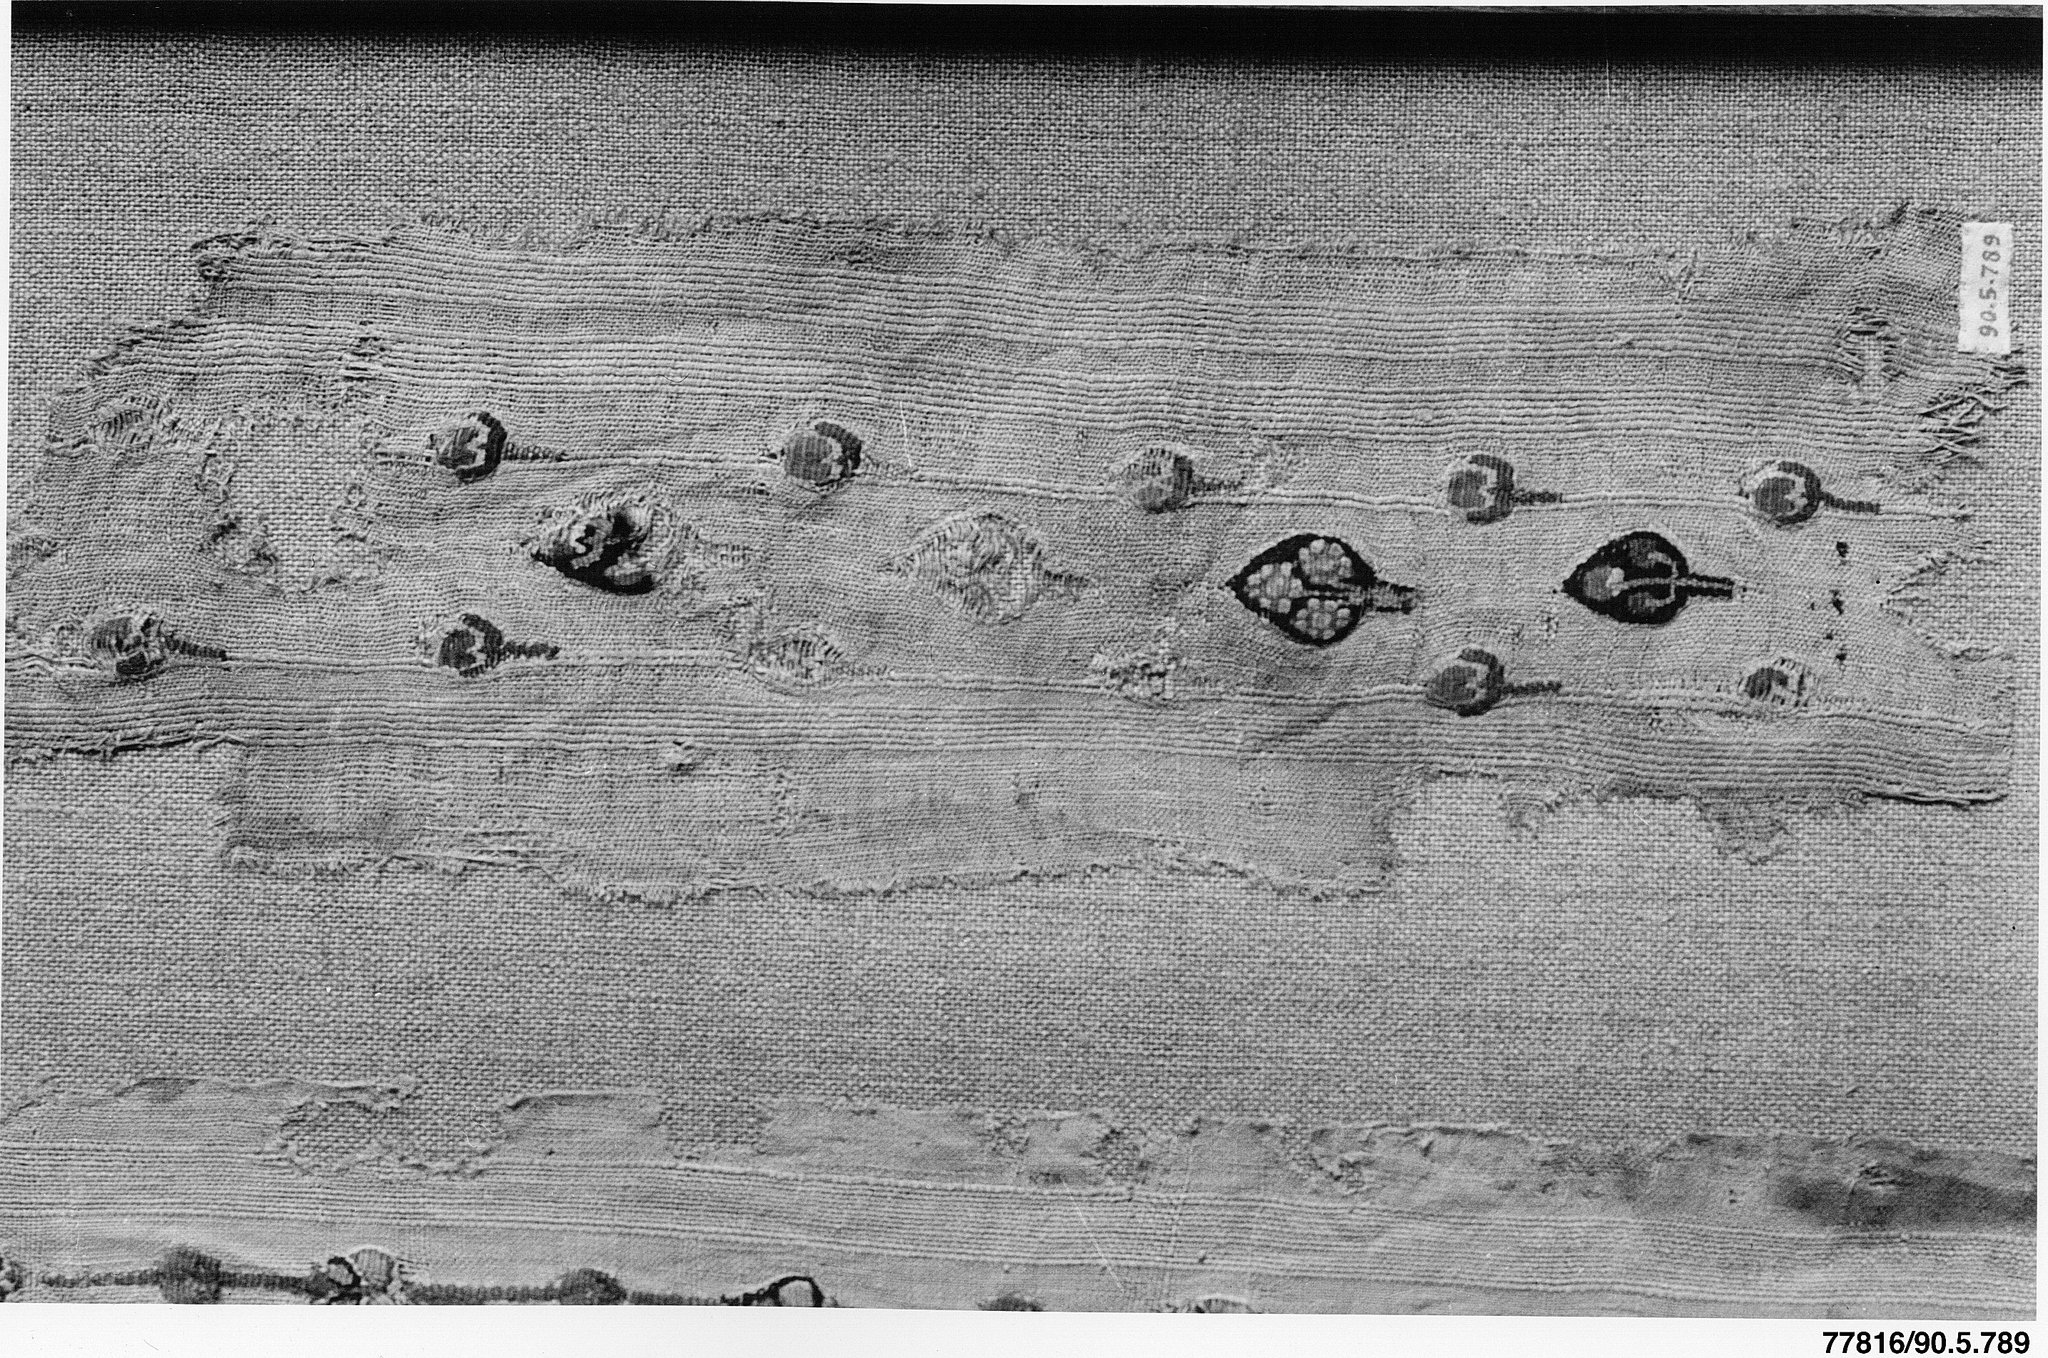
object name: textile fragment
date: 401-500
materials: linen, wool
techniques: weave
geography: egypt